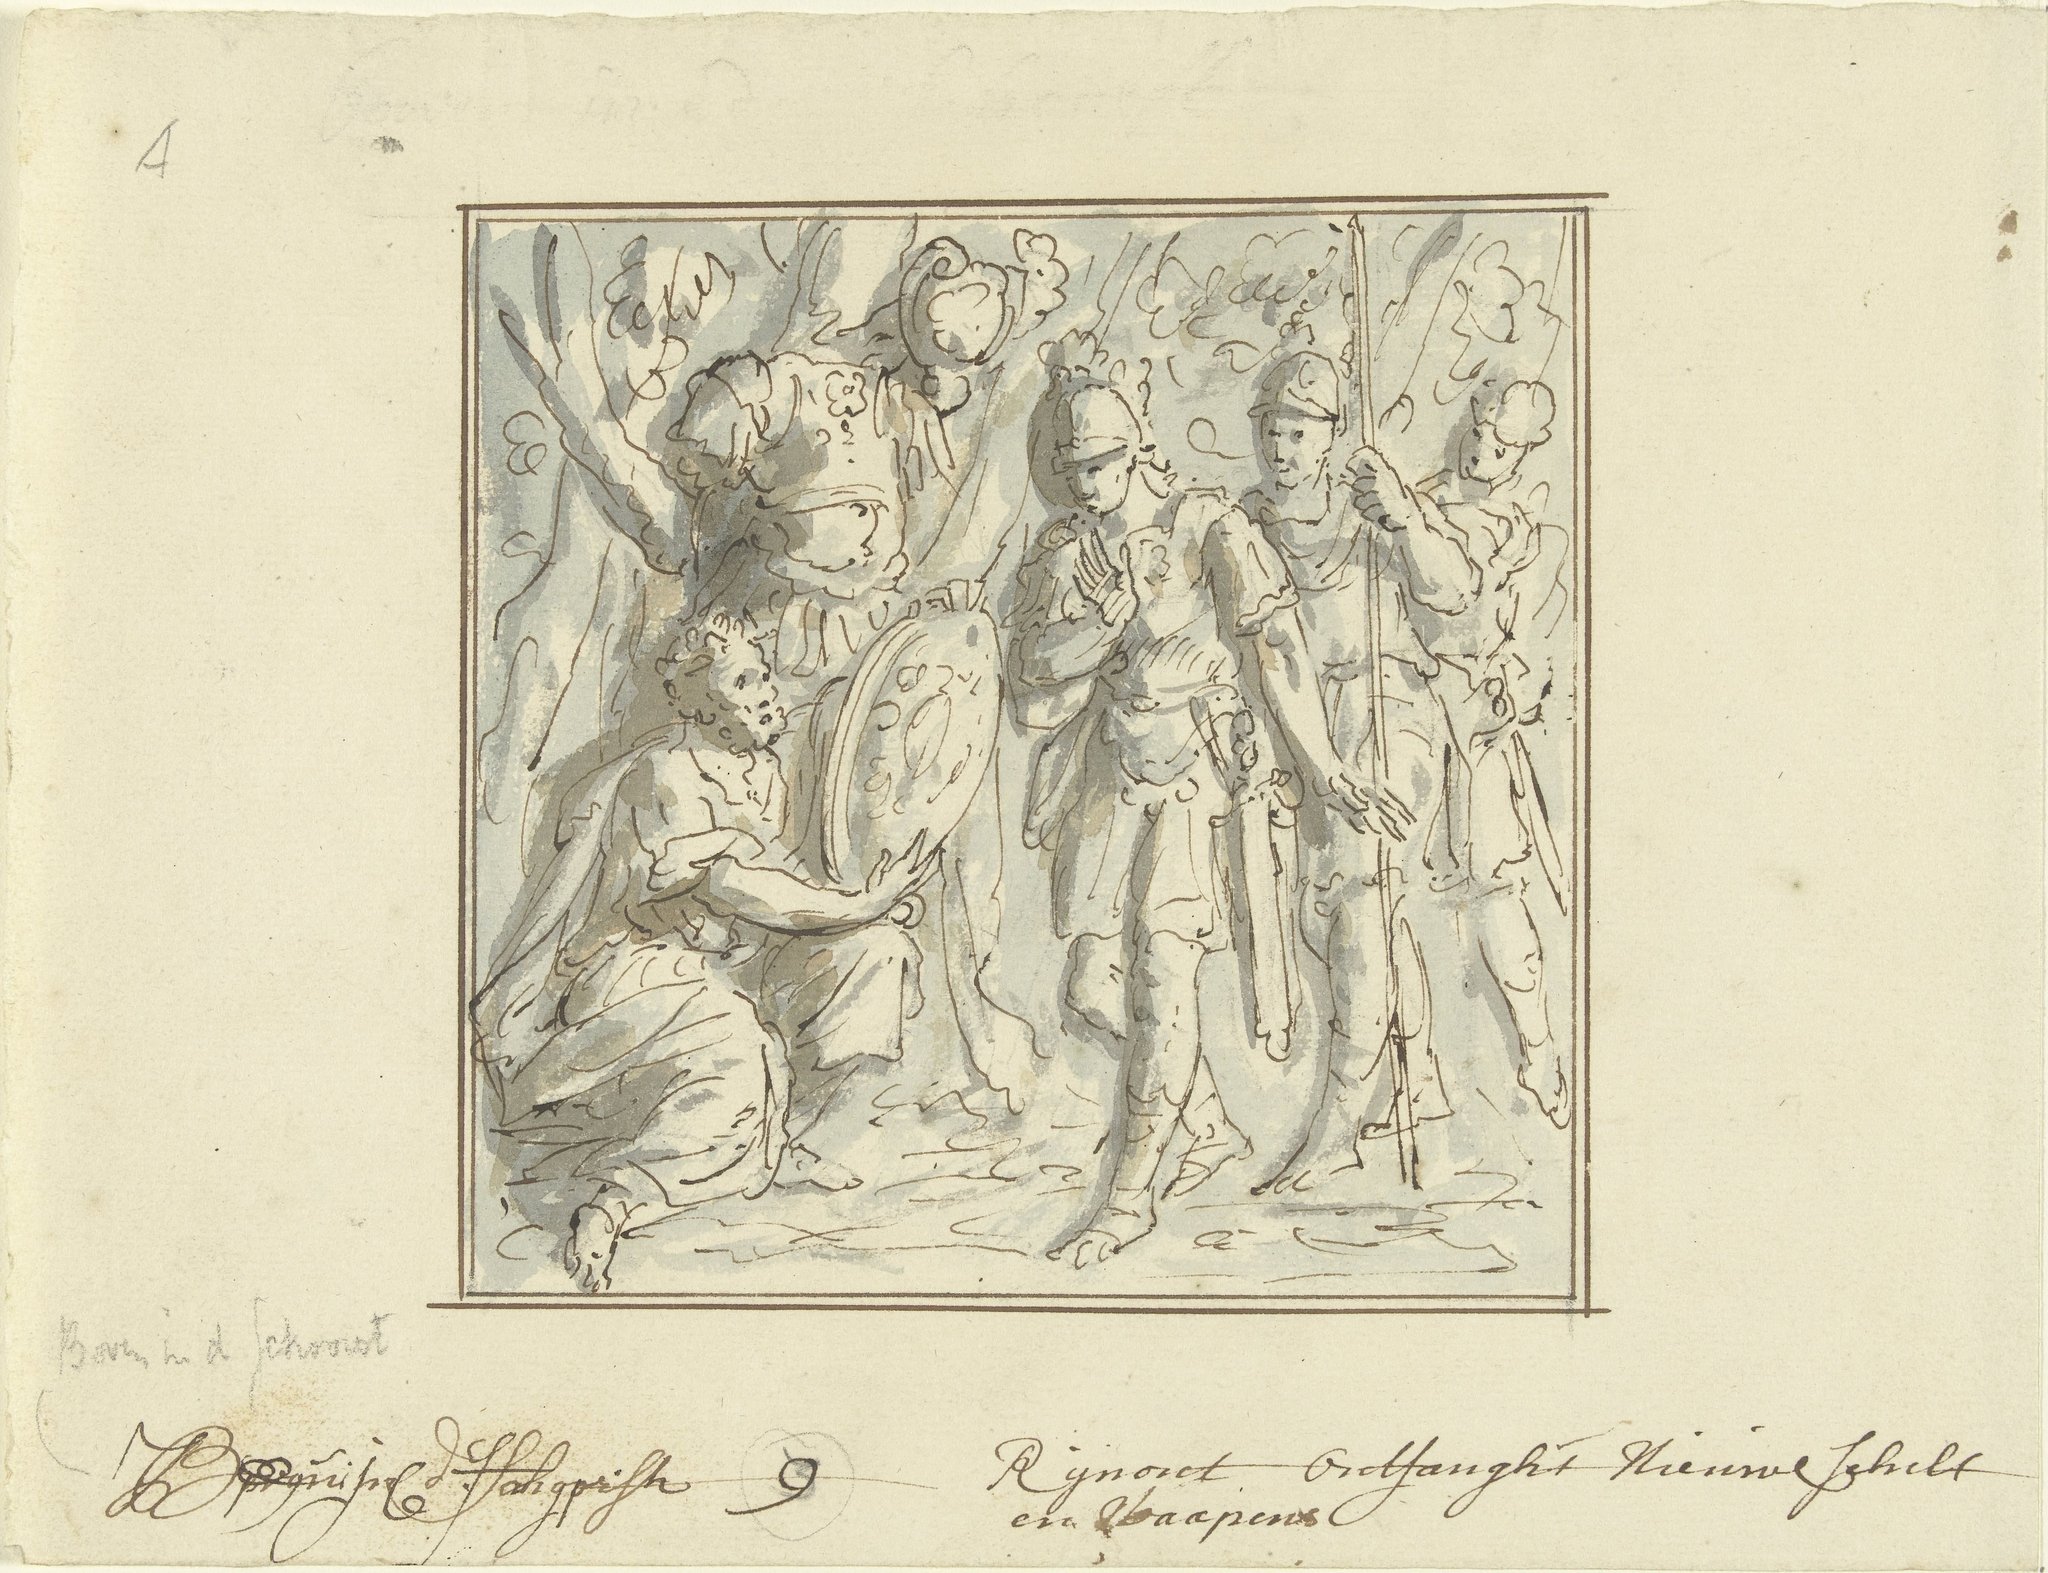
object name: design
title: Rinaldo krijgt nieuwe wapens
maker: elias van nijmegen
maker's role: draughtsman, painter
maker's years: 1667-1755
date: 1677-1755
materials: ink, paper, watercolor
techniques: brush, pen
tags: rinaldo